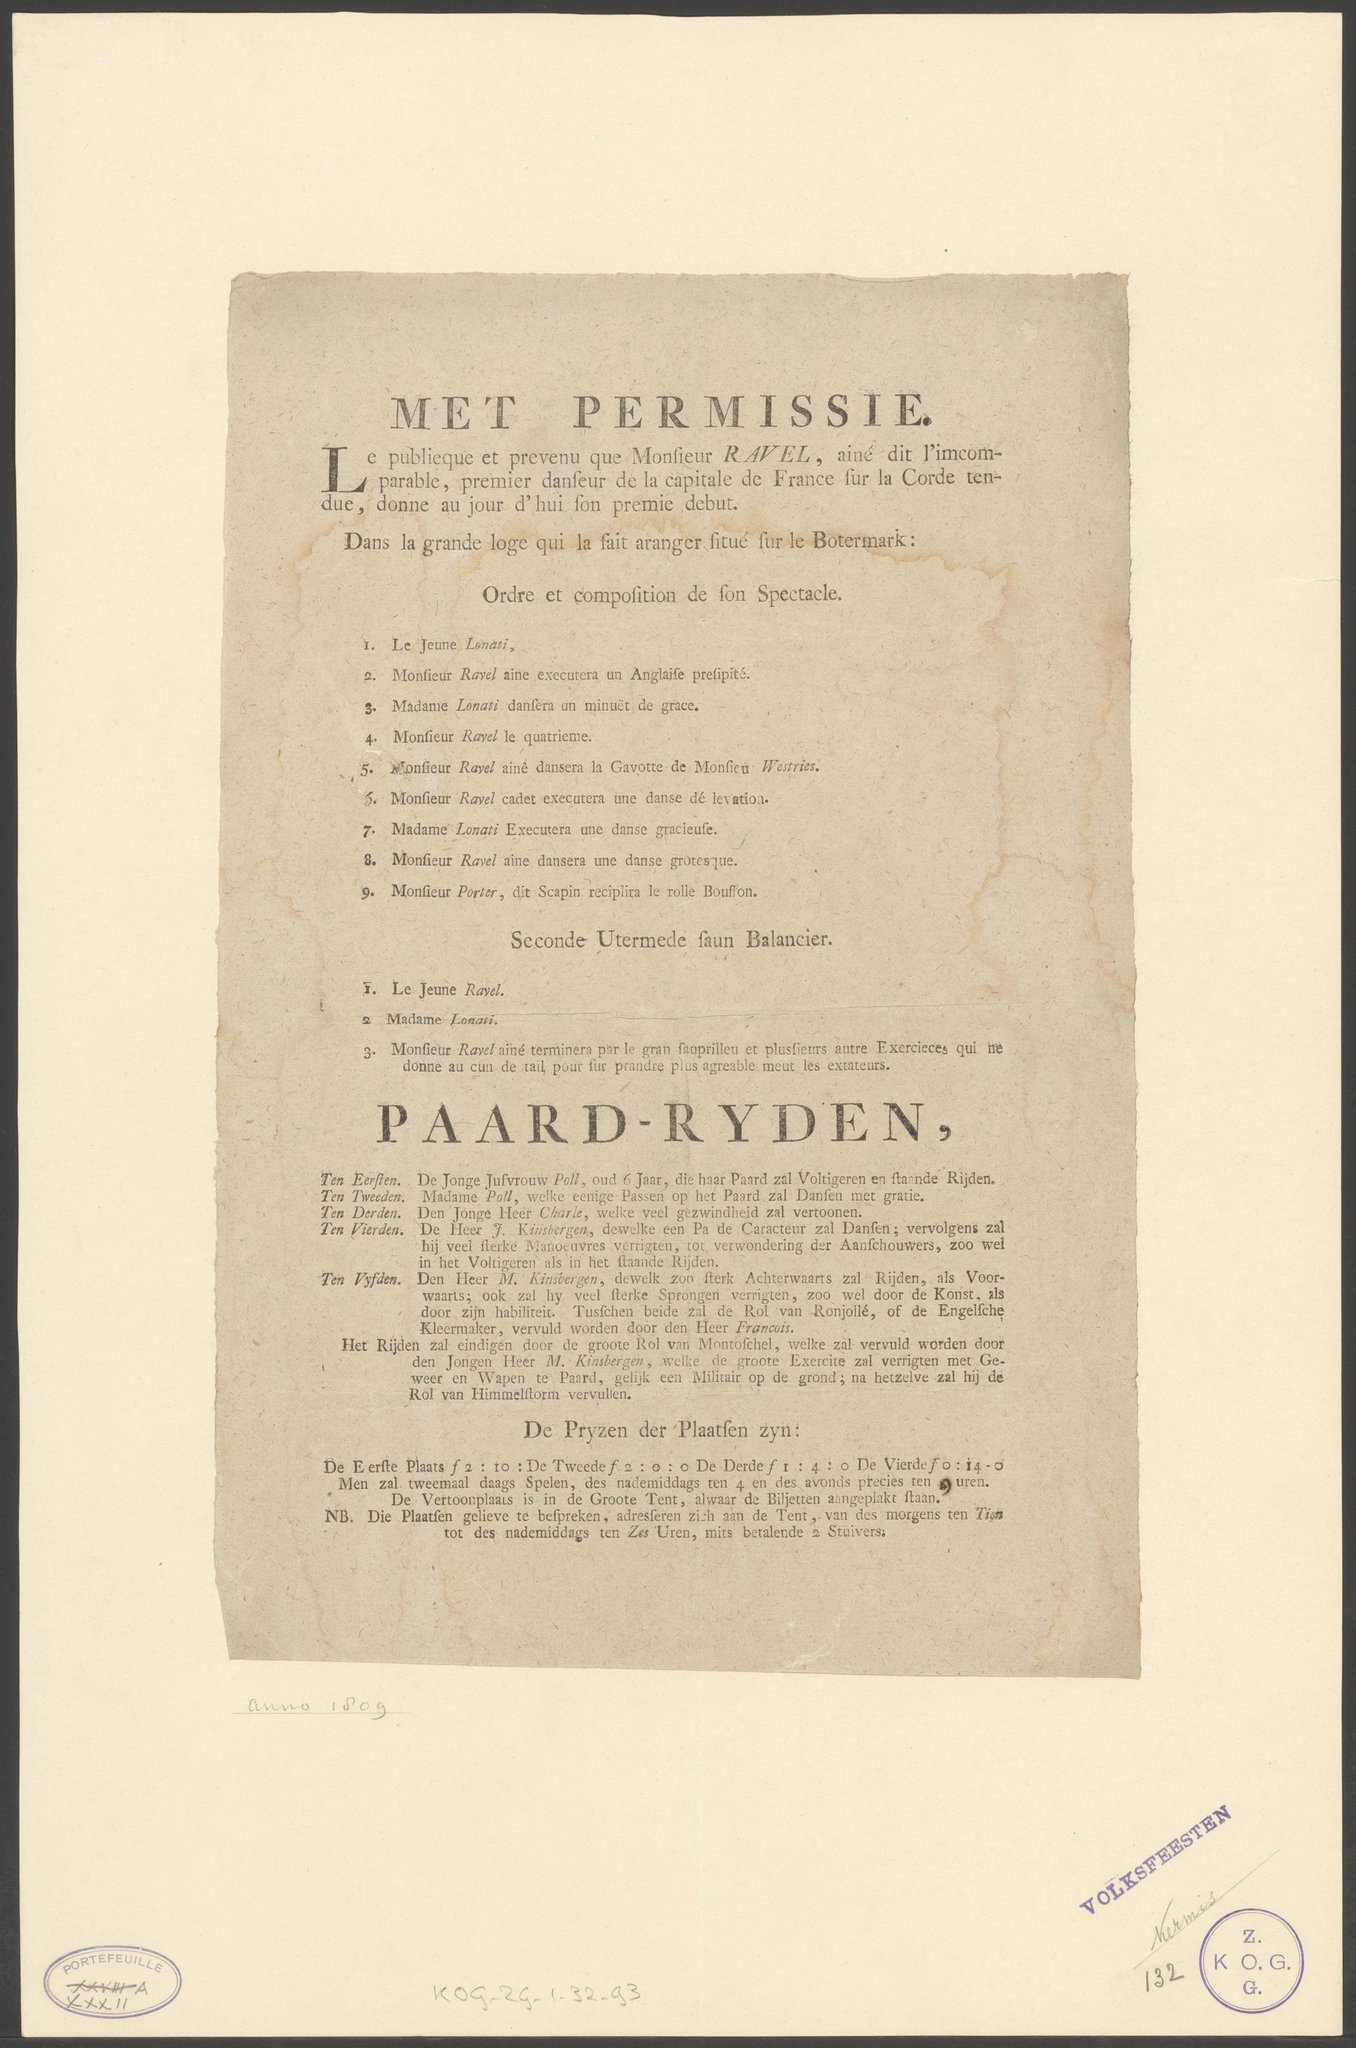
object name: reclamebiljet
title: Met Permissie. Paard-Ryden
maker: Anonymous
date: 1809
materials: paper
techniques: letterpress printing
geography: amsterdam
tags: circus animals, pleasure fair and circus, horses (circus performance), amsterdam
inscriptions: collector's mark: Lugt 1641, collector's mark